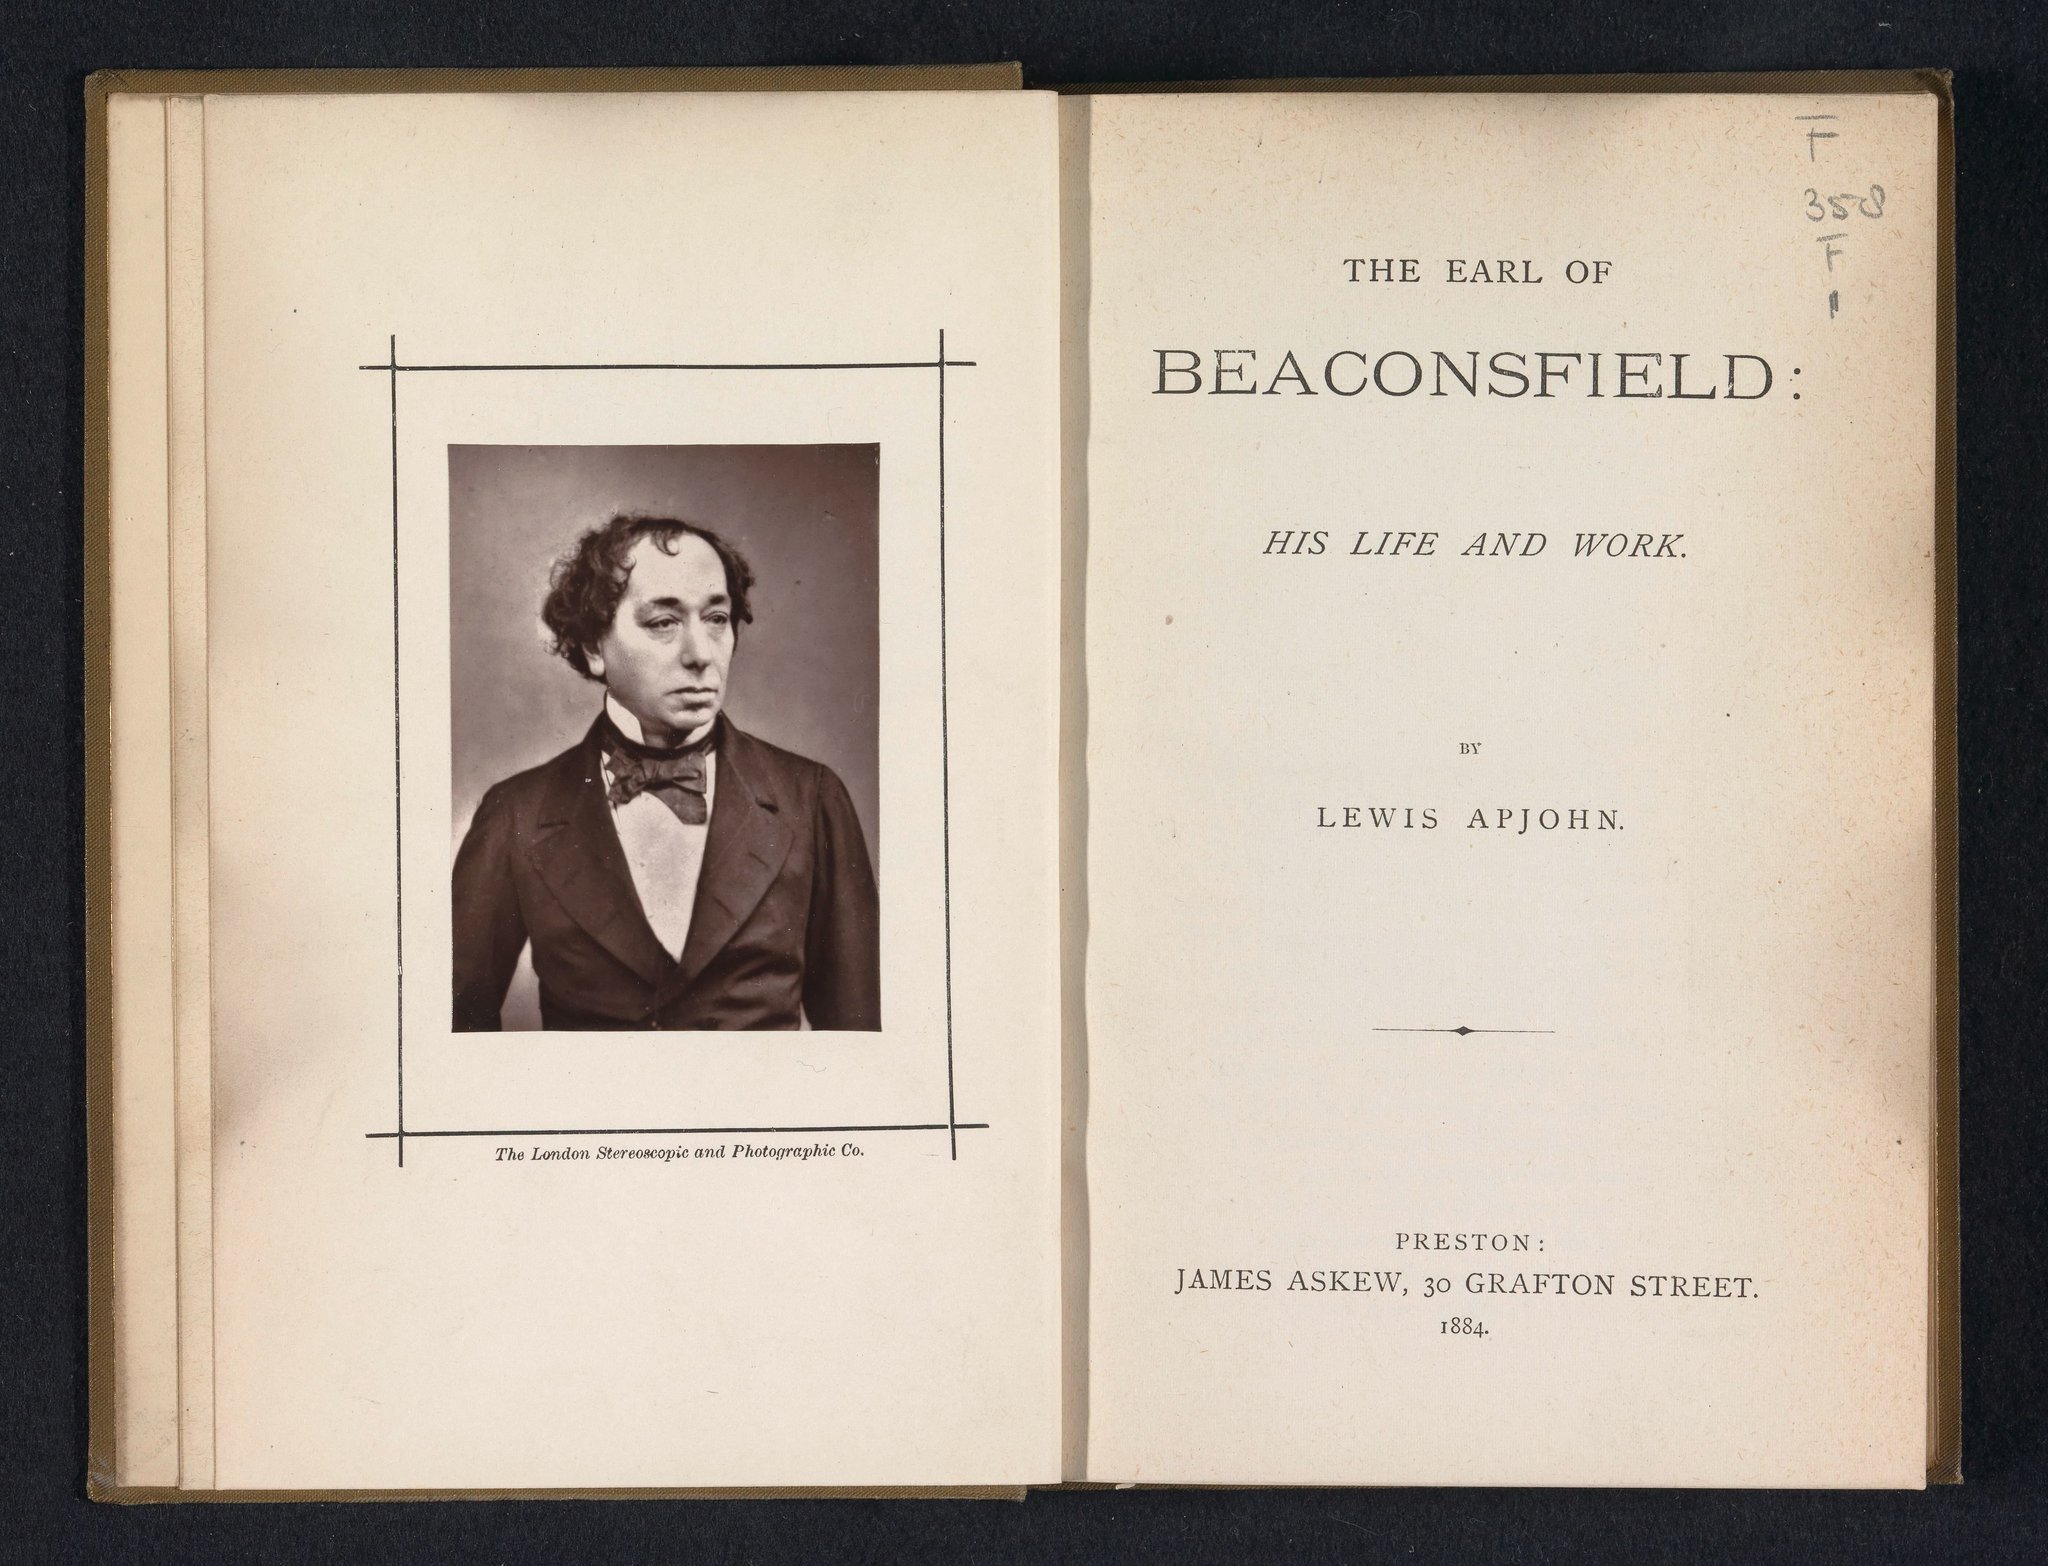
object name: book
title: The earl of Beaconsfield his life and work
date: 1884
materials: cardboard, linen, paper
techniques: woodburytype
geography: preston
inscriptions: bookplate: ‘ex libris SFJ’